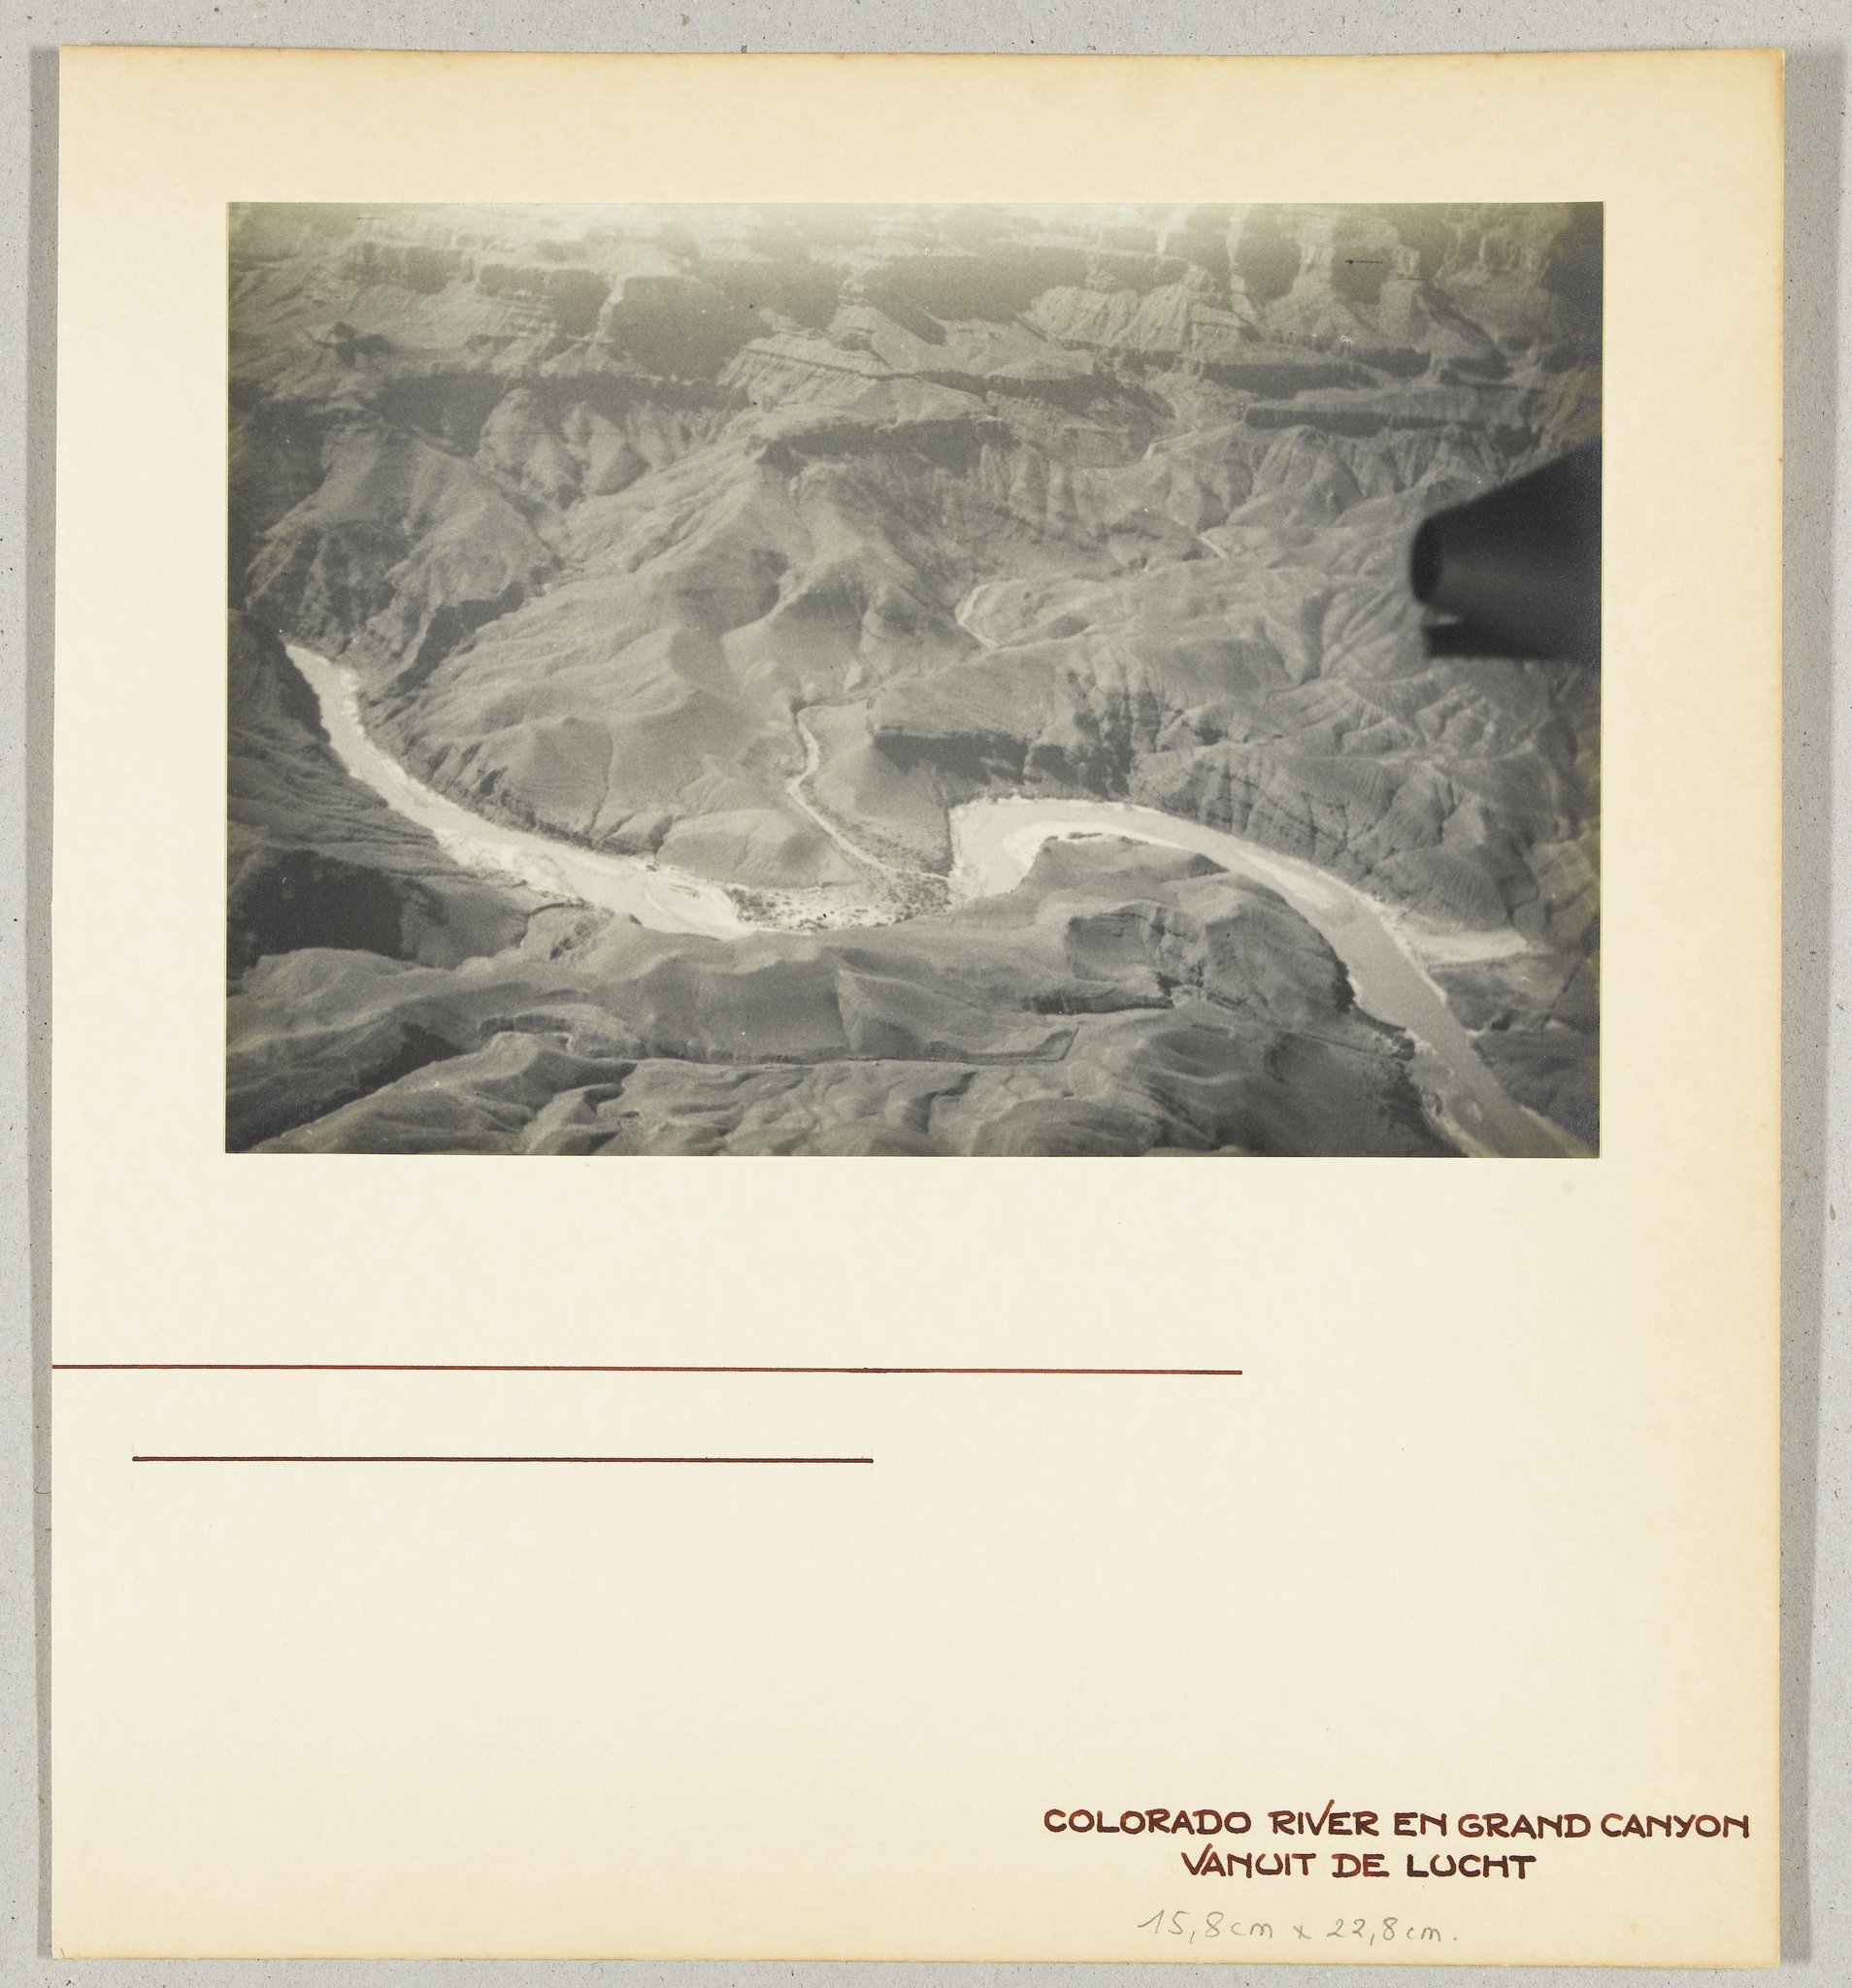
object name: photograph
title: Colorado river en Grand Canyon vanuit de lucht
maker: wouter cool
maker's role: engineer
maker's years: 1877-1947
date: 1936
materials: cardboard, paper, photographic support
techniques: gelatin silver print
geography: united states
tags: river, ravine, chasm, abyss, canyon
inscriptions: title: ‘COLORADO RIVER EN GRAND CANYON / VANUIT DE LUCHT’